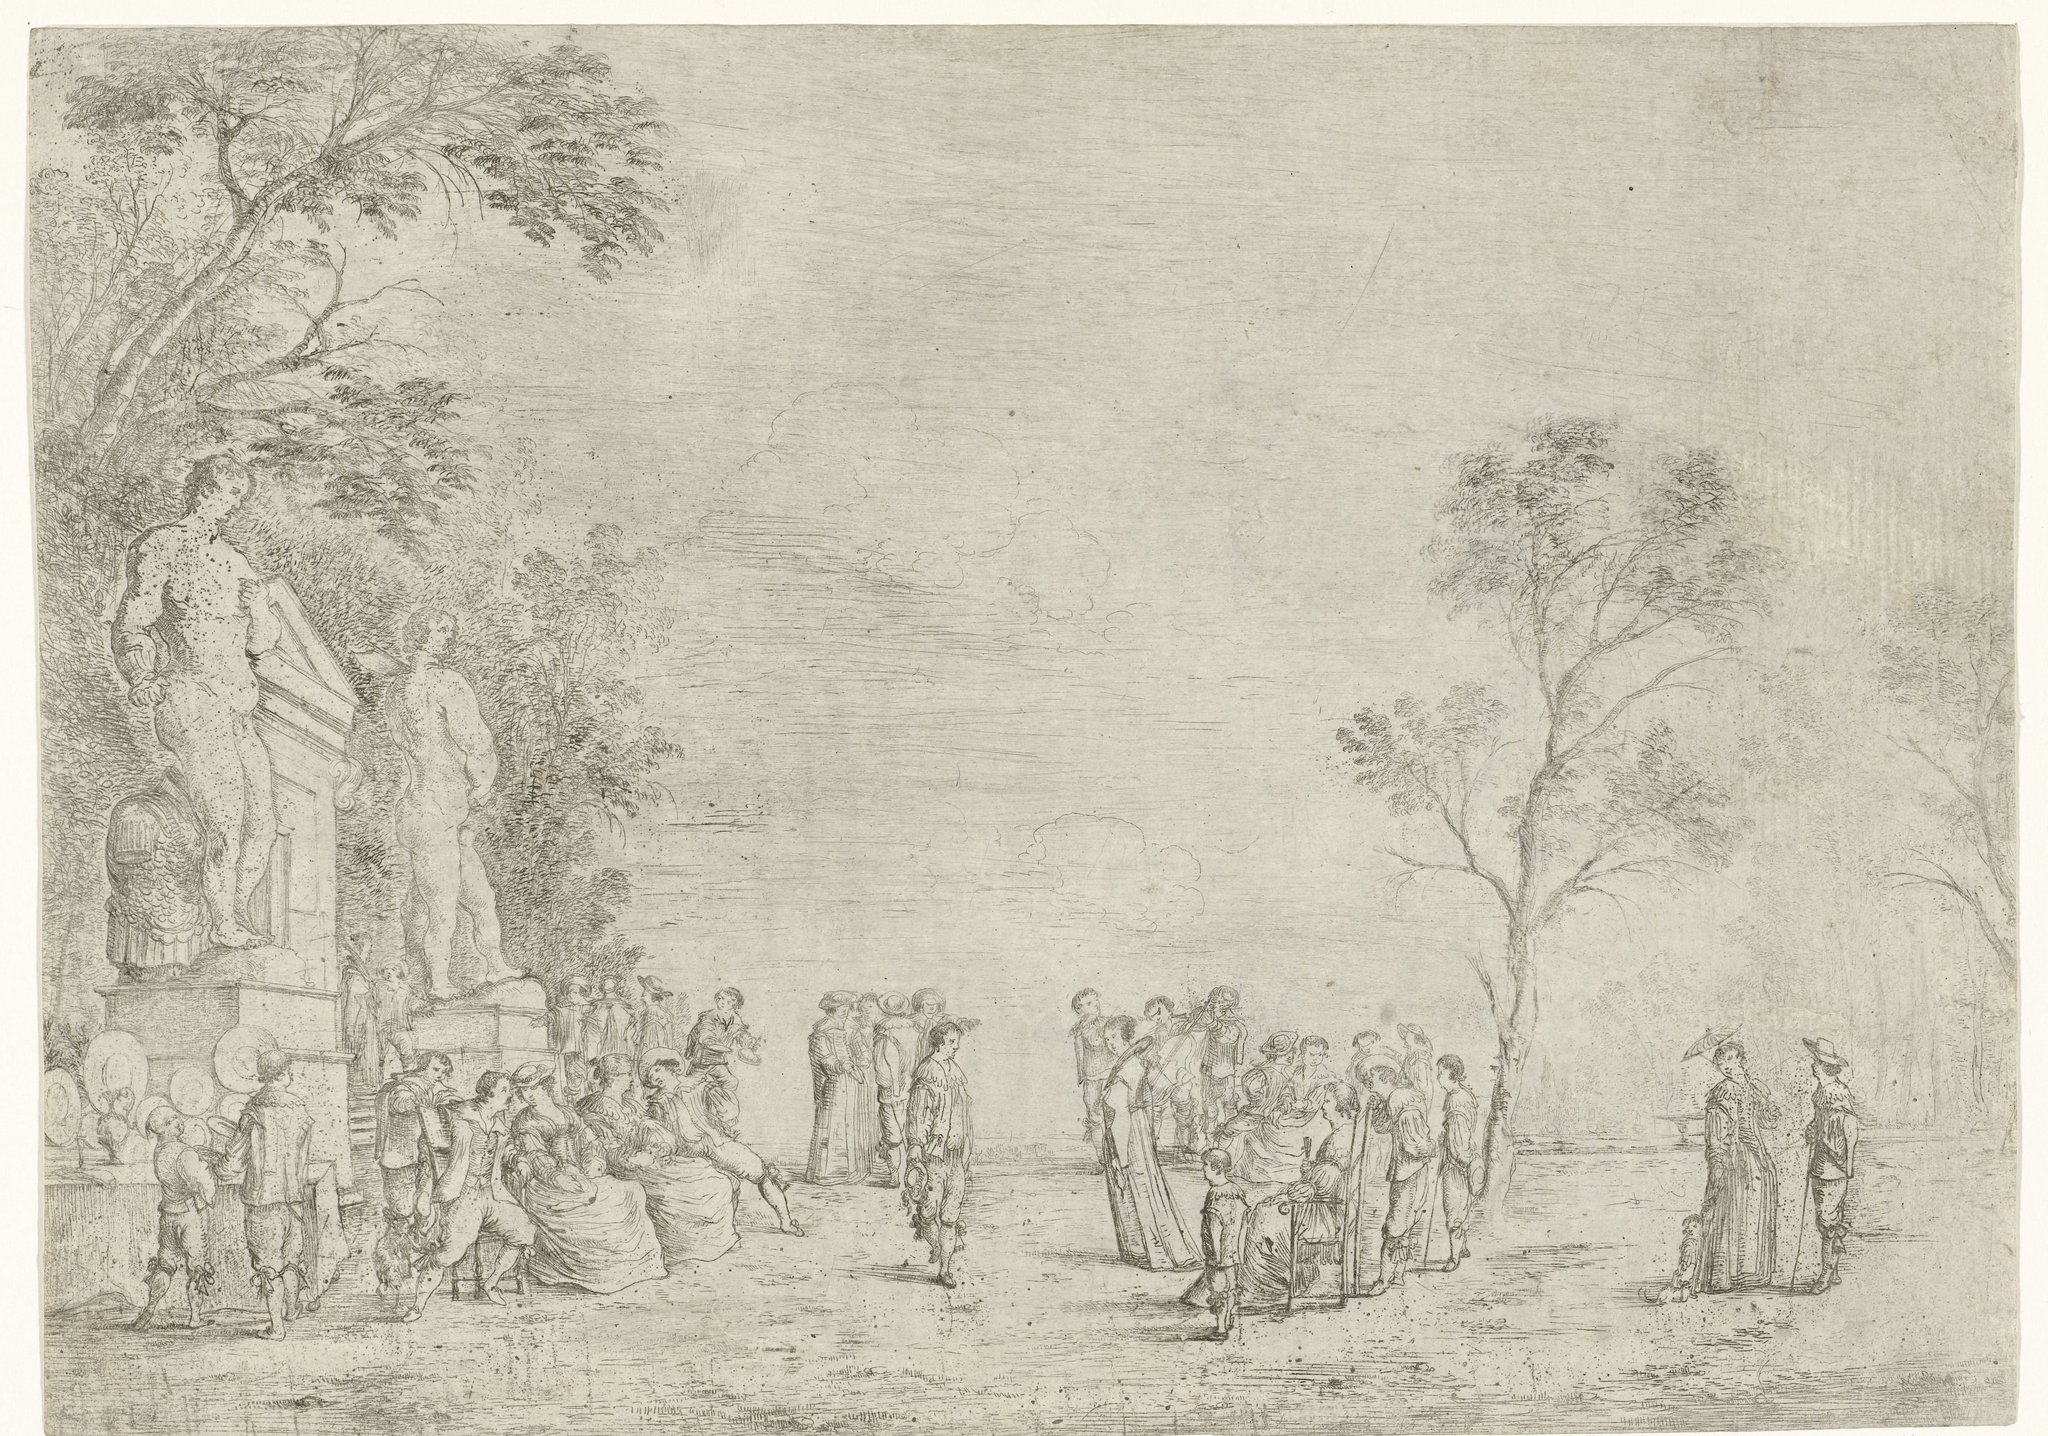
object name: print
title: Festival in een park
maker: jan fouceel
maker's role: print maker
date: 1665-1675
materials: paper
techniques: etching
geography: antwerp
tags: park, one pair dancing; man and woman dancing as a couple, ornamental fountain, festivities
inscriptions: collector's mark: Lugt 2228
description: In een park zitten enkele fraai geklede dames en heren te drinken en te praten voor een architecturale fontein met twee grote beelden. Tegenover hen bevindt zich een tweede gezelschap. In het midden een dansend paar.